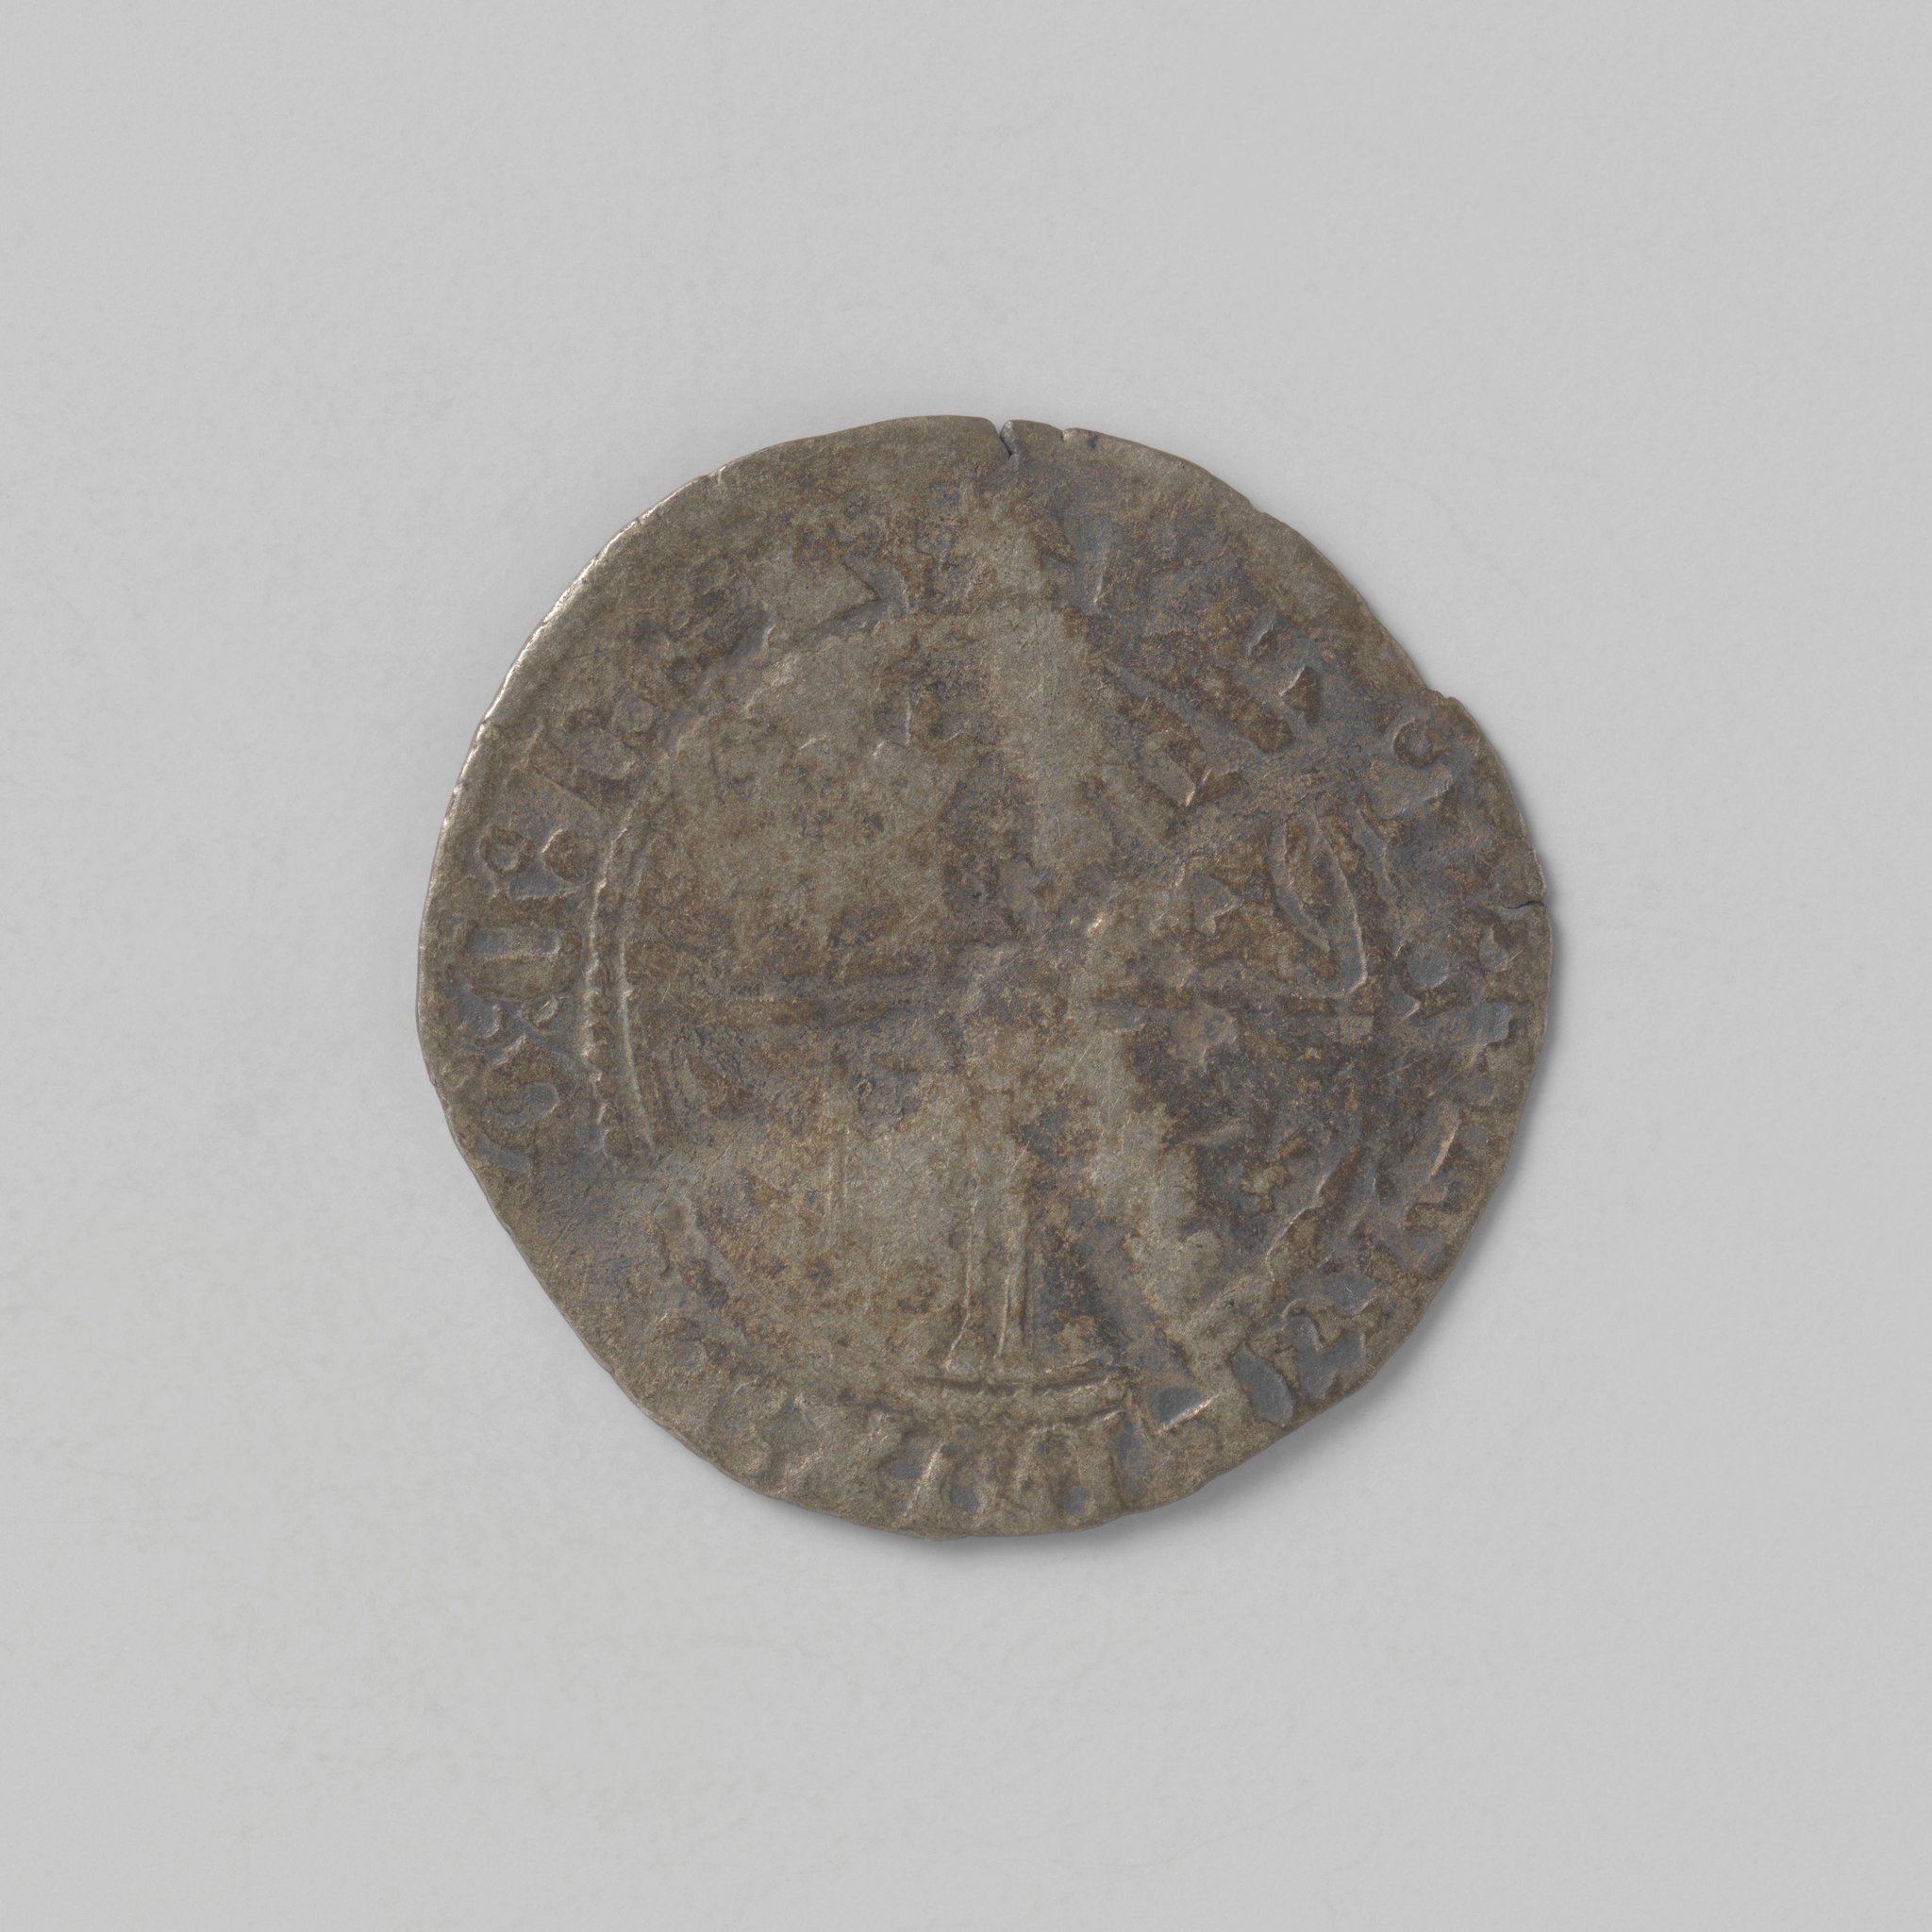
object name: halve groot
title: Holland, Philips de Goede, halve groot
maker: philip iii the good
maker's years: 1396-1467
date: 1434-1467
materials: silver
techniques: striking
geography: dordrecht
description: Zilveren munt. Voorzijde: wapenschild van Philips de Goede in veld. Keerzijde: lang gevoet kruis, in hoeken afwisselend lelies en leeuwtjes, in het hart roos.